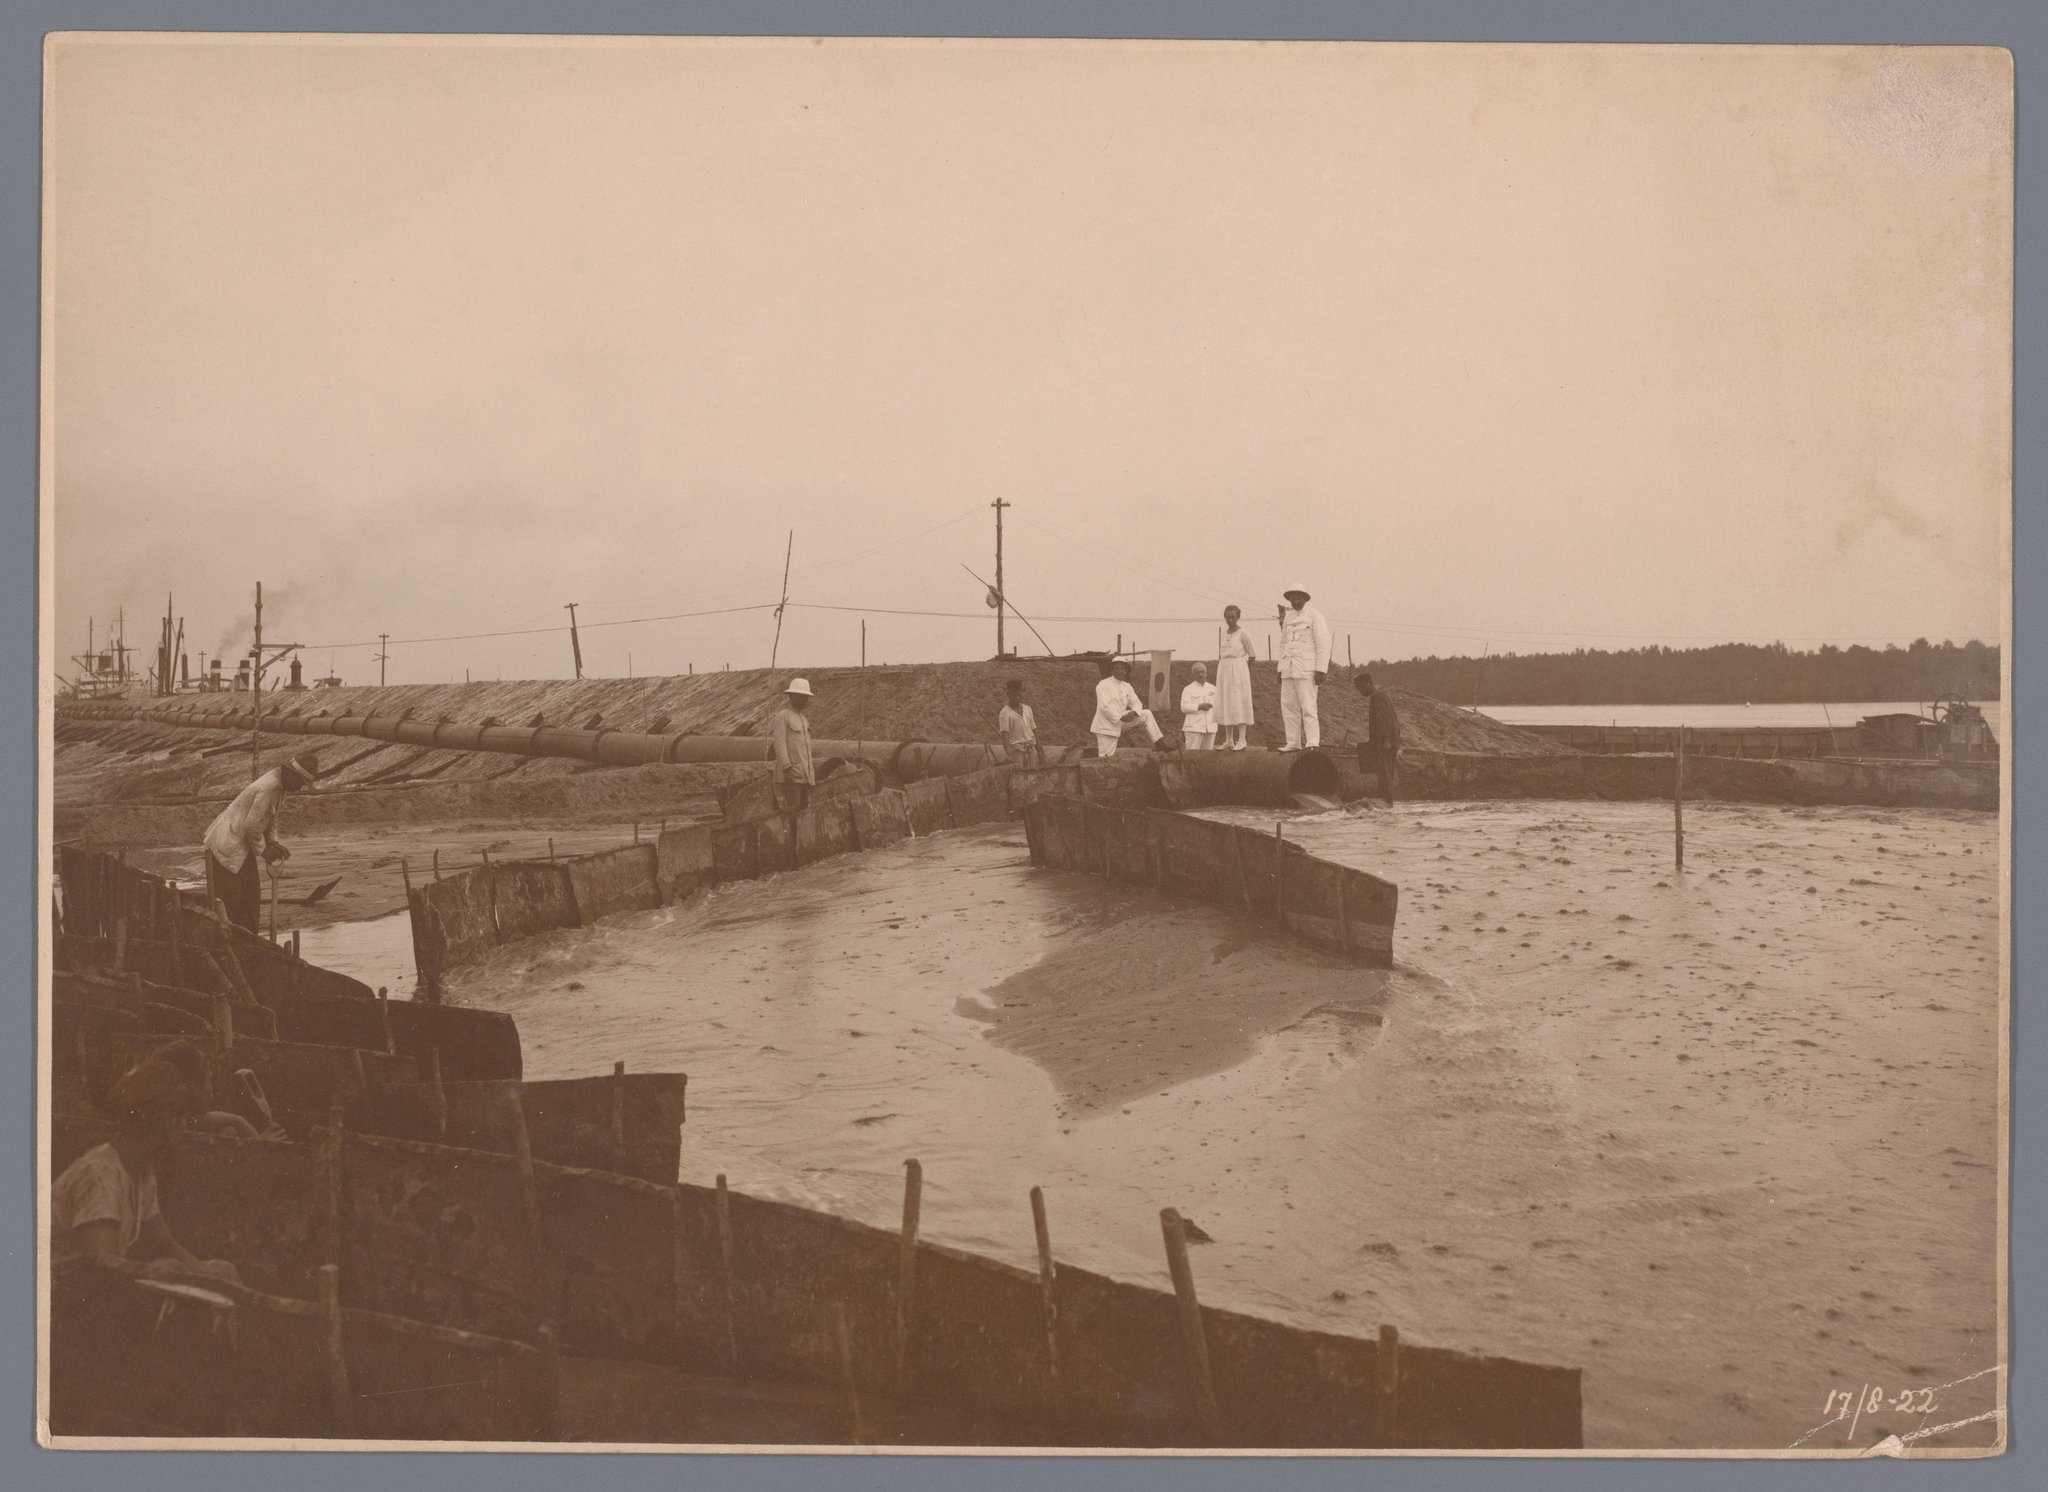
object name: photograph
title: Zand spuiten i/d grondverbetering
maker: Anonymous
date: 1922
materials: photographic support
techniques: gelatin silver print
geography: belawan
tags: harbour, building-site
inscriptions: annotation: ‘No. 187 / Zand spuiten i/d grondverbetering’, date: ‘17/8-22’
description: Het opspuiten van zand. Genummerd: 187. Onderdeel van de groep van losse foto's over de aanleg van de haven Belawan aan de kust voor Medan, Sumatra 1921-1922.